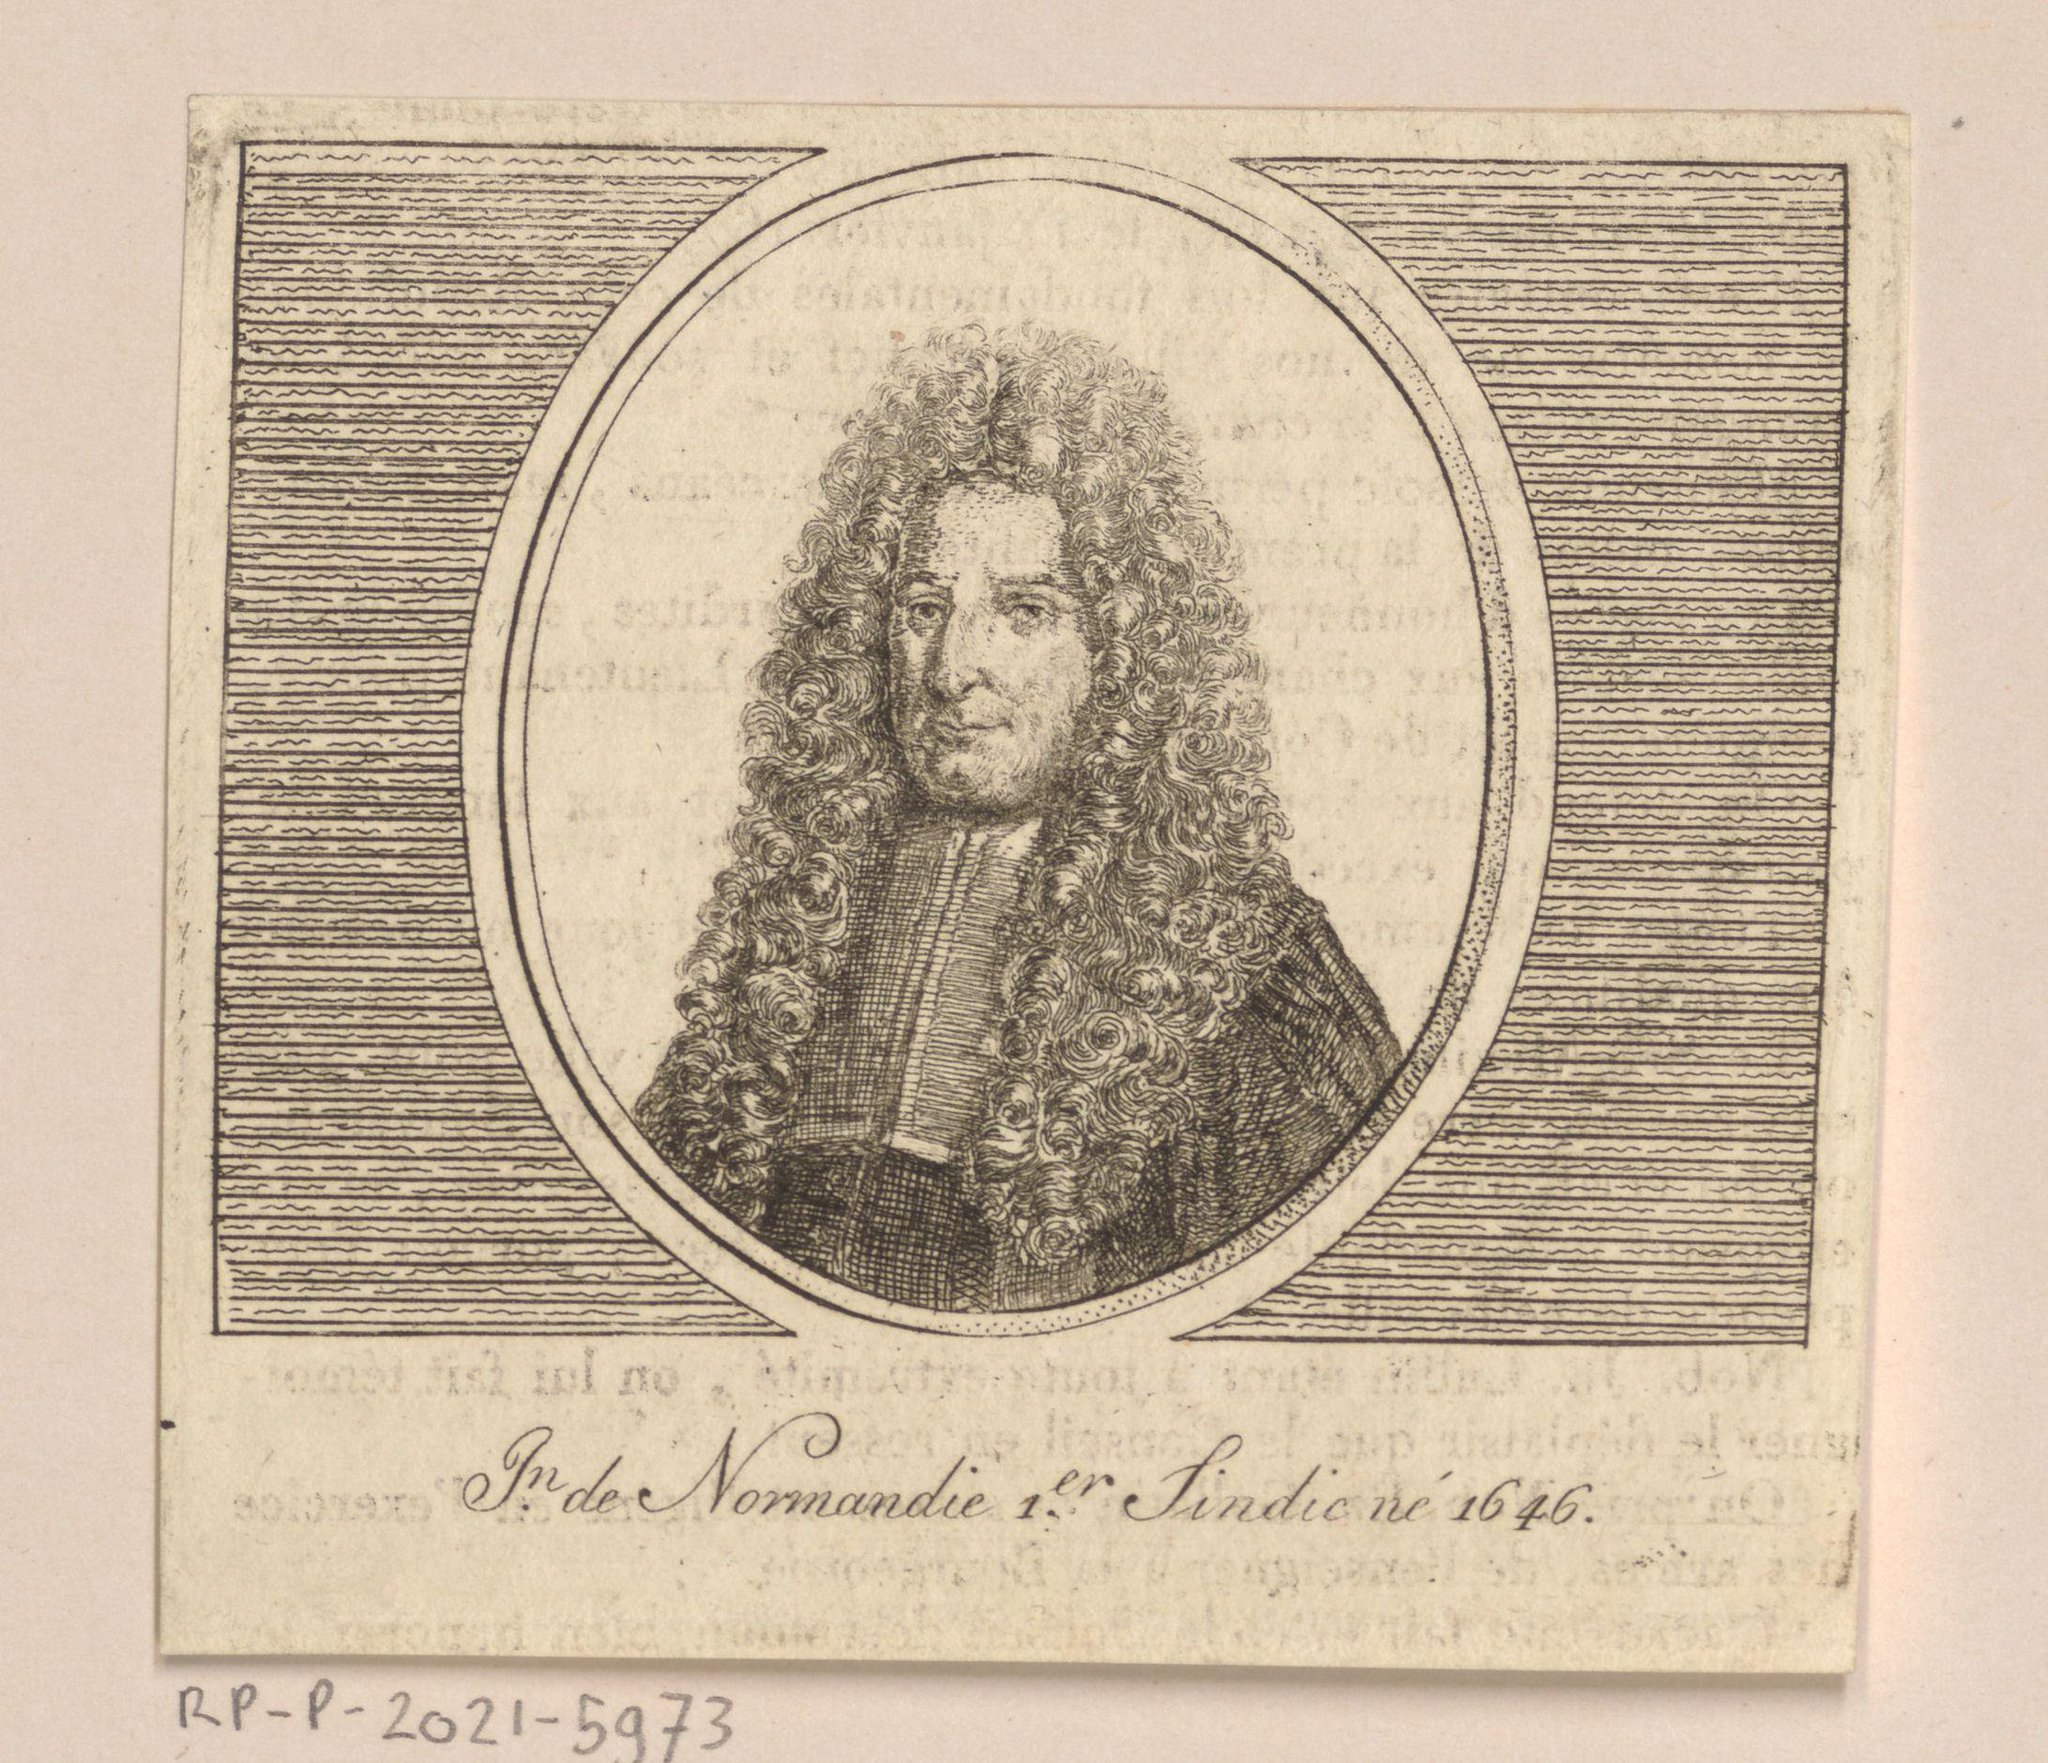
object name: book illustration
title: Portret van Jean de Normandie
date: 1815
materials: paper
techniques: etching, letterpress printing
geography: geneva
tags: historical persons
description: Prent uit: Grenus, Théodore de. Fragmens biographiques et historiques. Extraits des registres du Conseil (...). Genève: Manget et Cherbuliez, 1815.